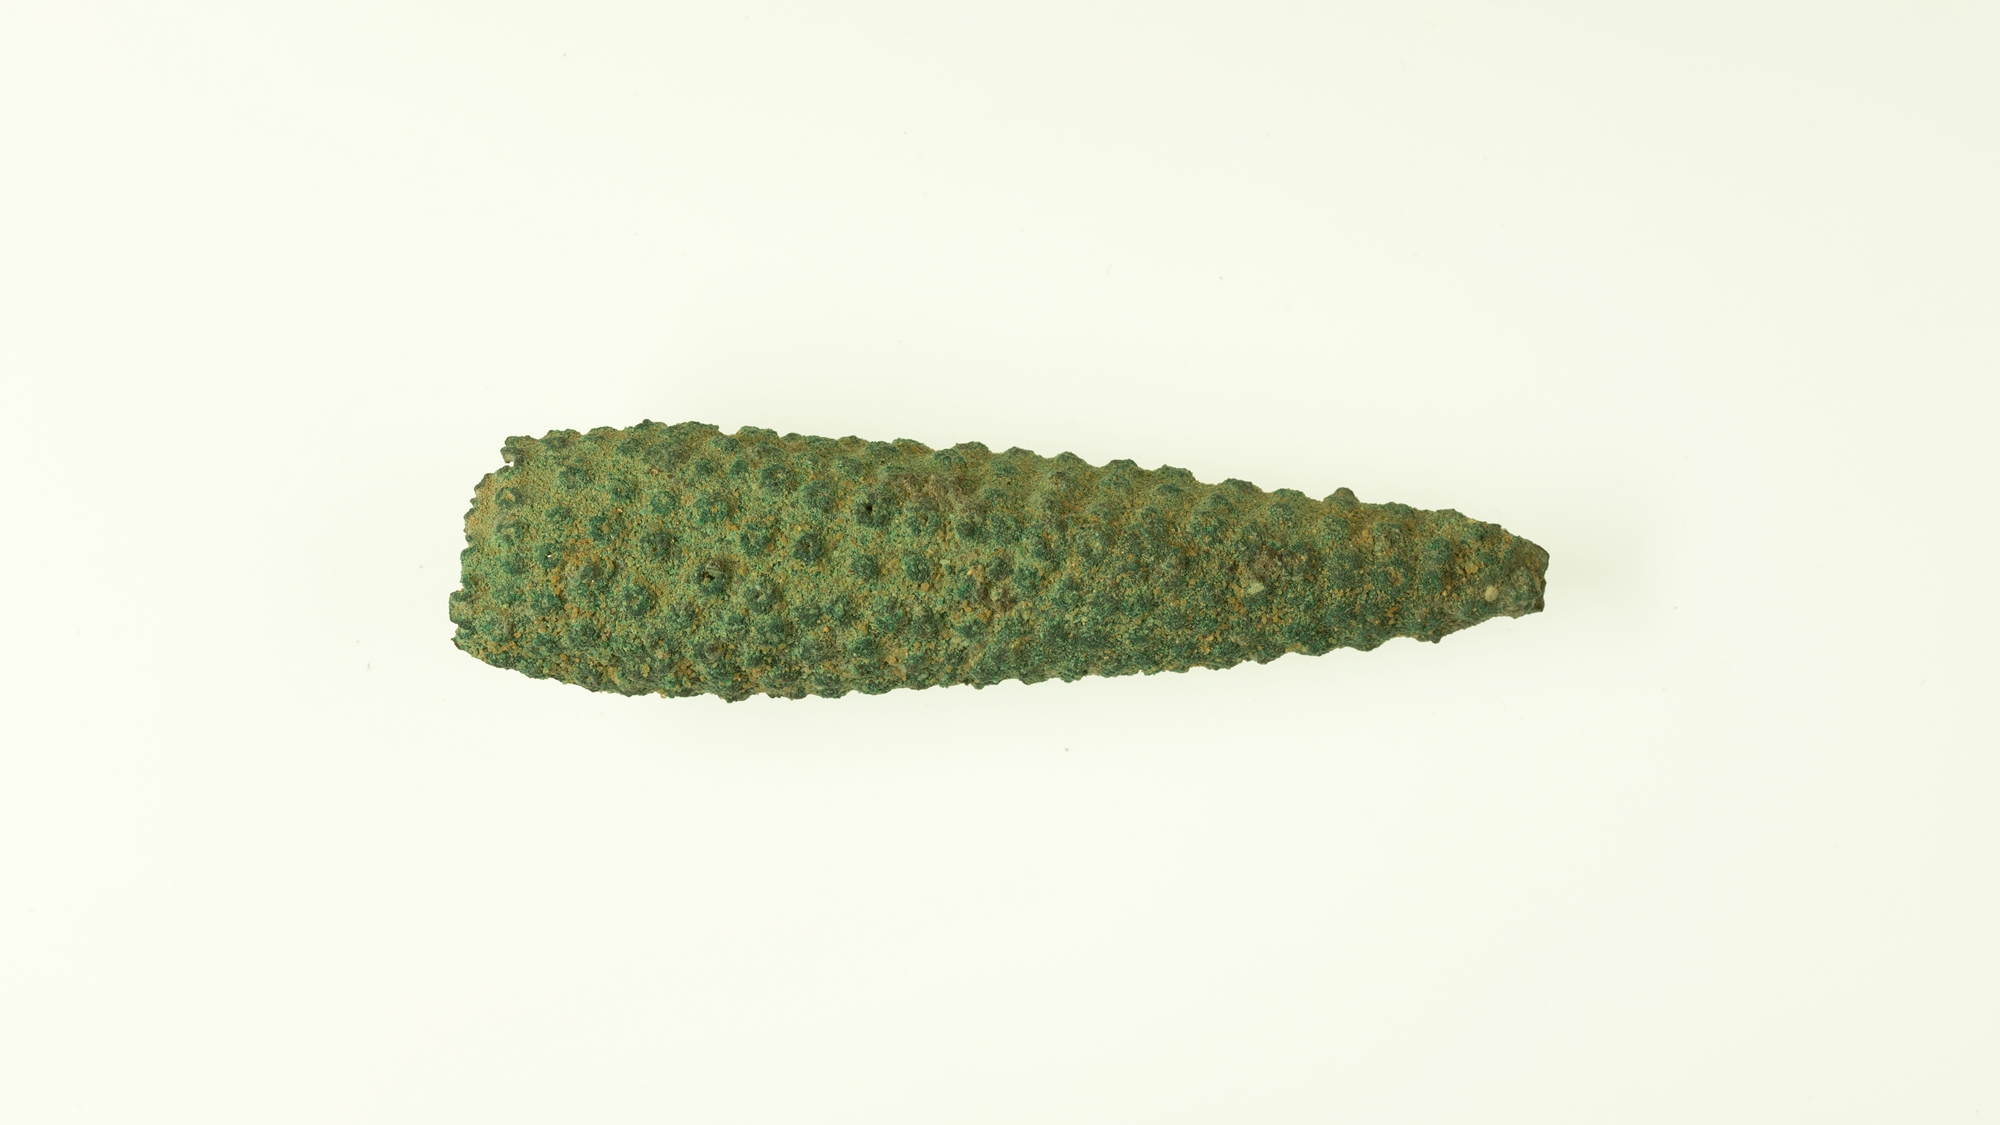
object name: siphon nozzle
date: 1295-1070 BCE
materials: bronze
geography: egypt